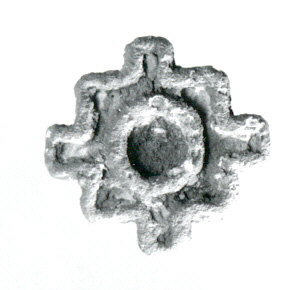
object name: stamp seal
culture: bactria-margiana archaeological complex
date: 2333-1668 BCE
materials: copper alloy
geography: bactria-margiana